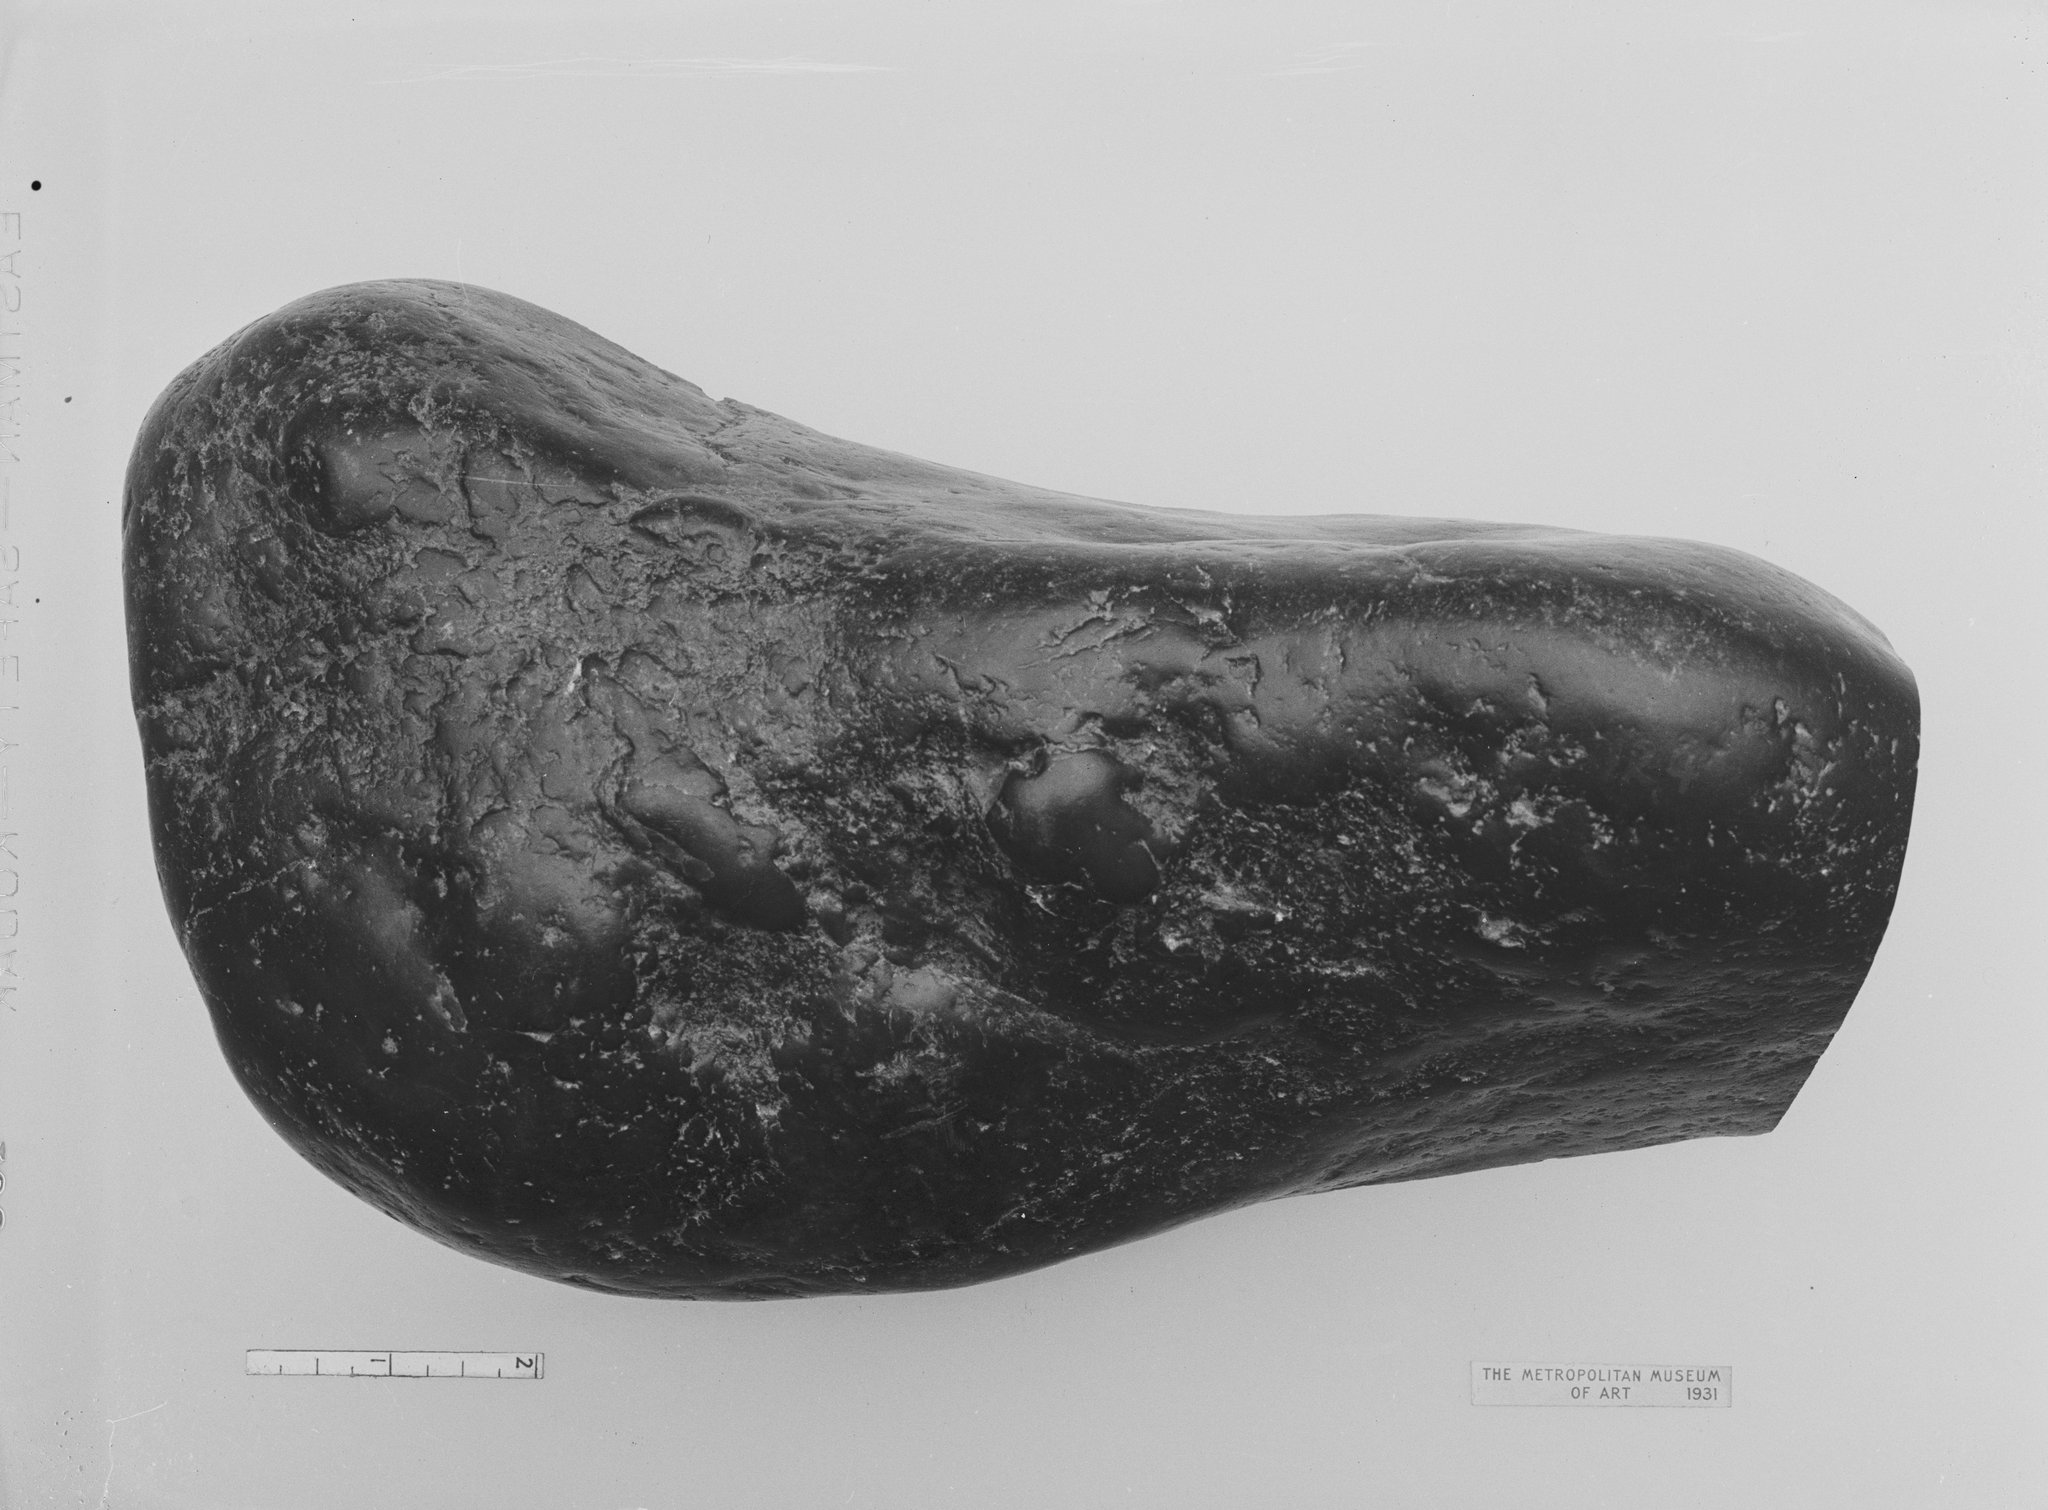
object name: fragment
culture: russian, siberia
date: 1902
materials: jade